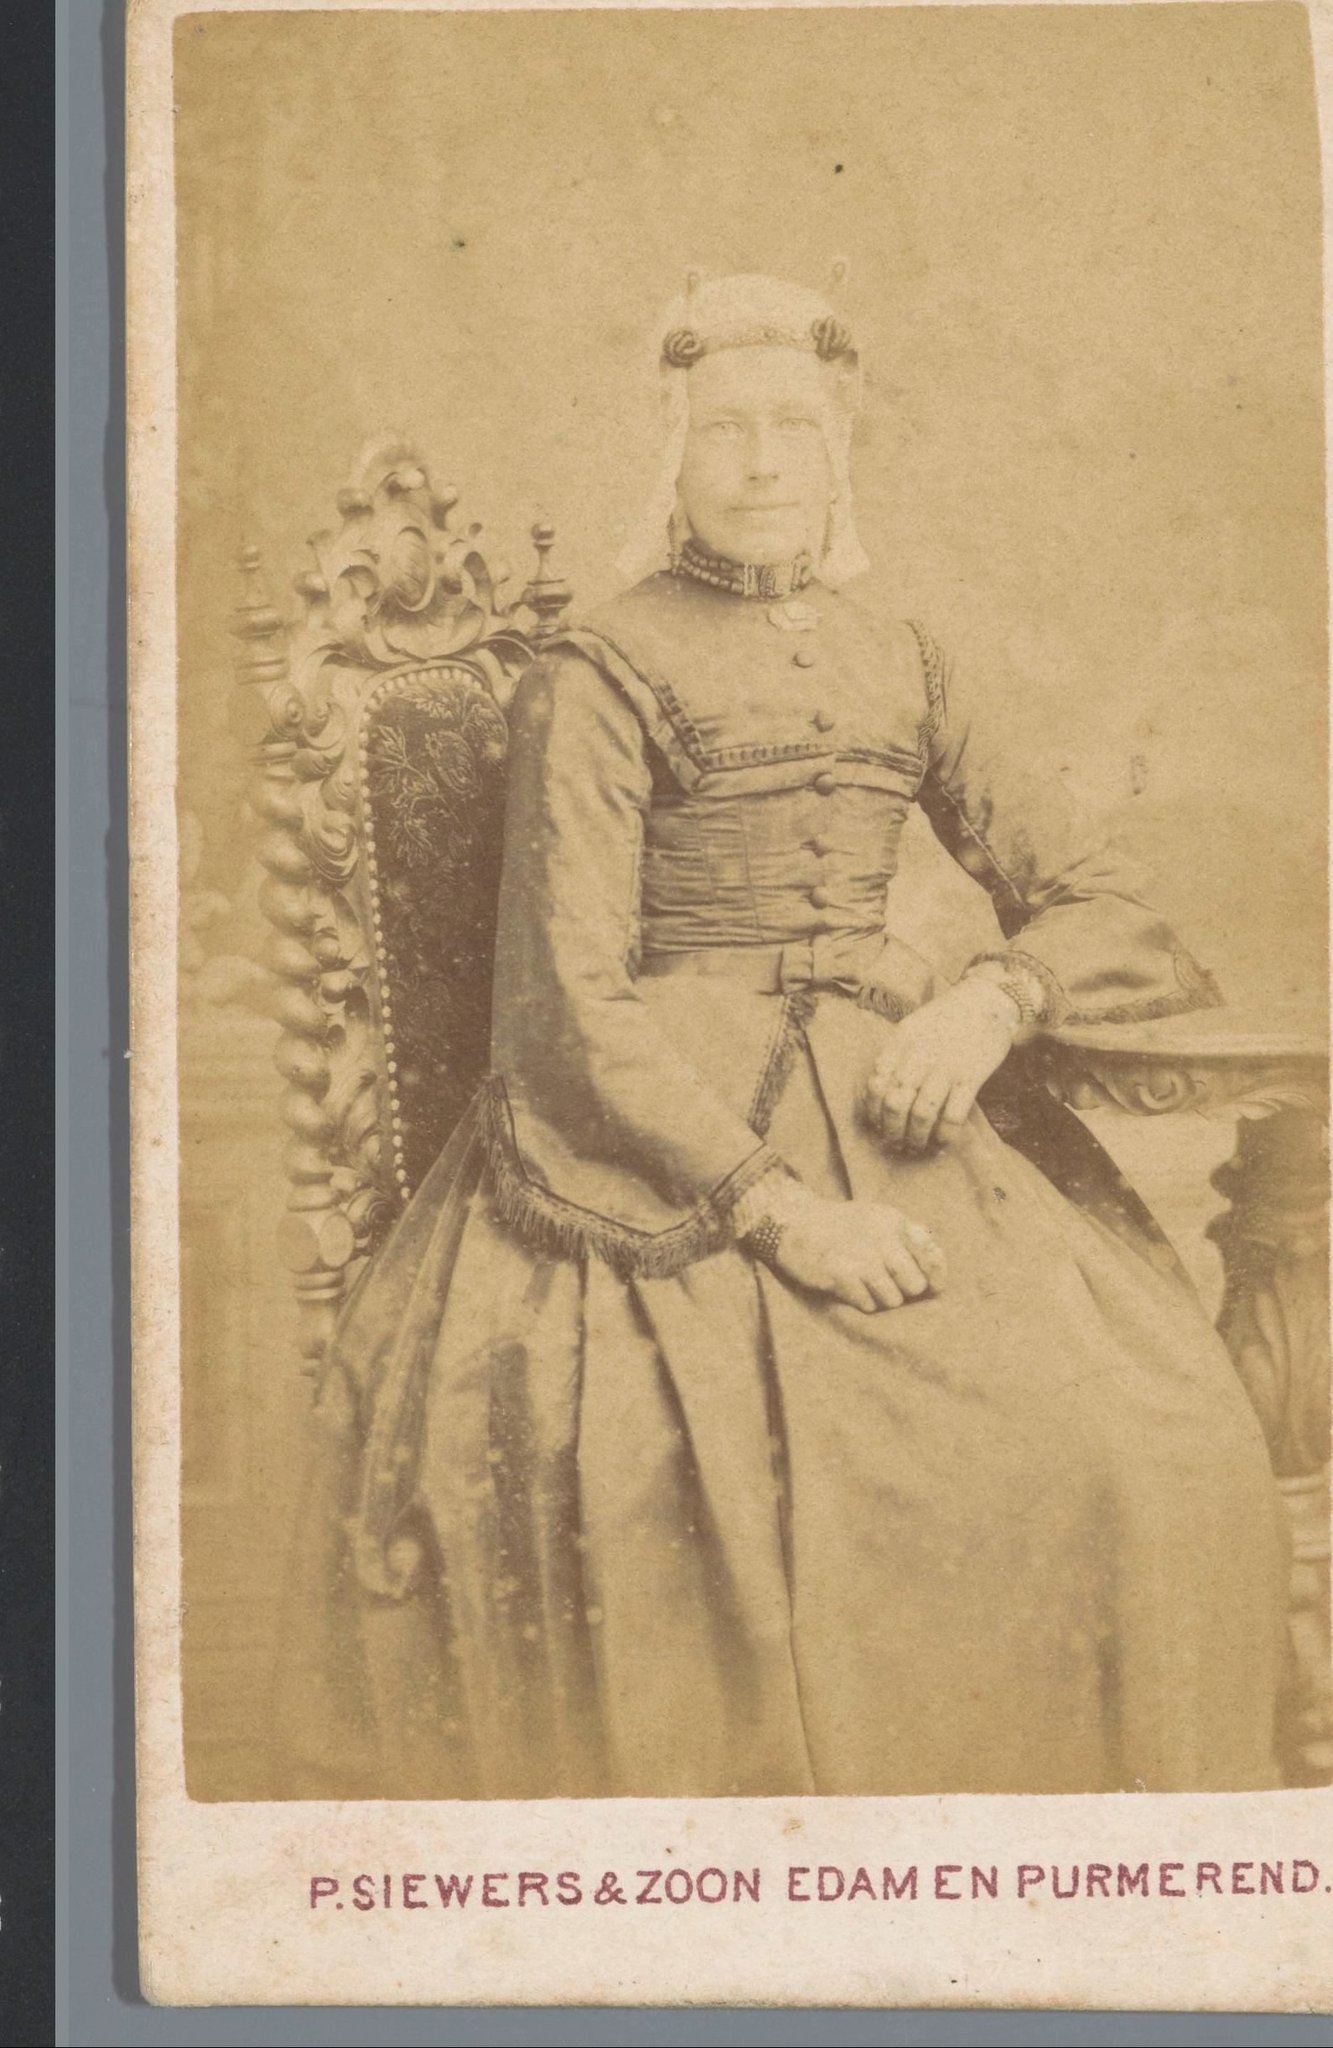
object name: carte de visite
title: Portret van Aagje Kramer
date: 1857-1898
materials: cardboard, paper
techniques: albumen print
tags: sitting figure, historical persons - bb - woman, head-gear: cap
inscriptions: inscription: ‘Aagje Kramer van J. Kelderman’, inscription: ‘Photographisch/ ATELIER/ P. Siewers & Zoon/ EDAM/ EN/ PURMEREND/ Te Edam dagelijks werkzaam/ Te Purmerend zondag & dinsdag/ de negatieven blijven bewaard tot nabestelling.’